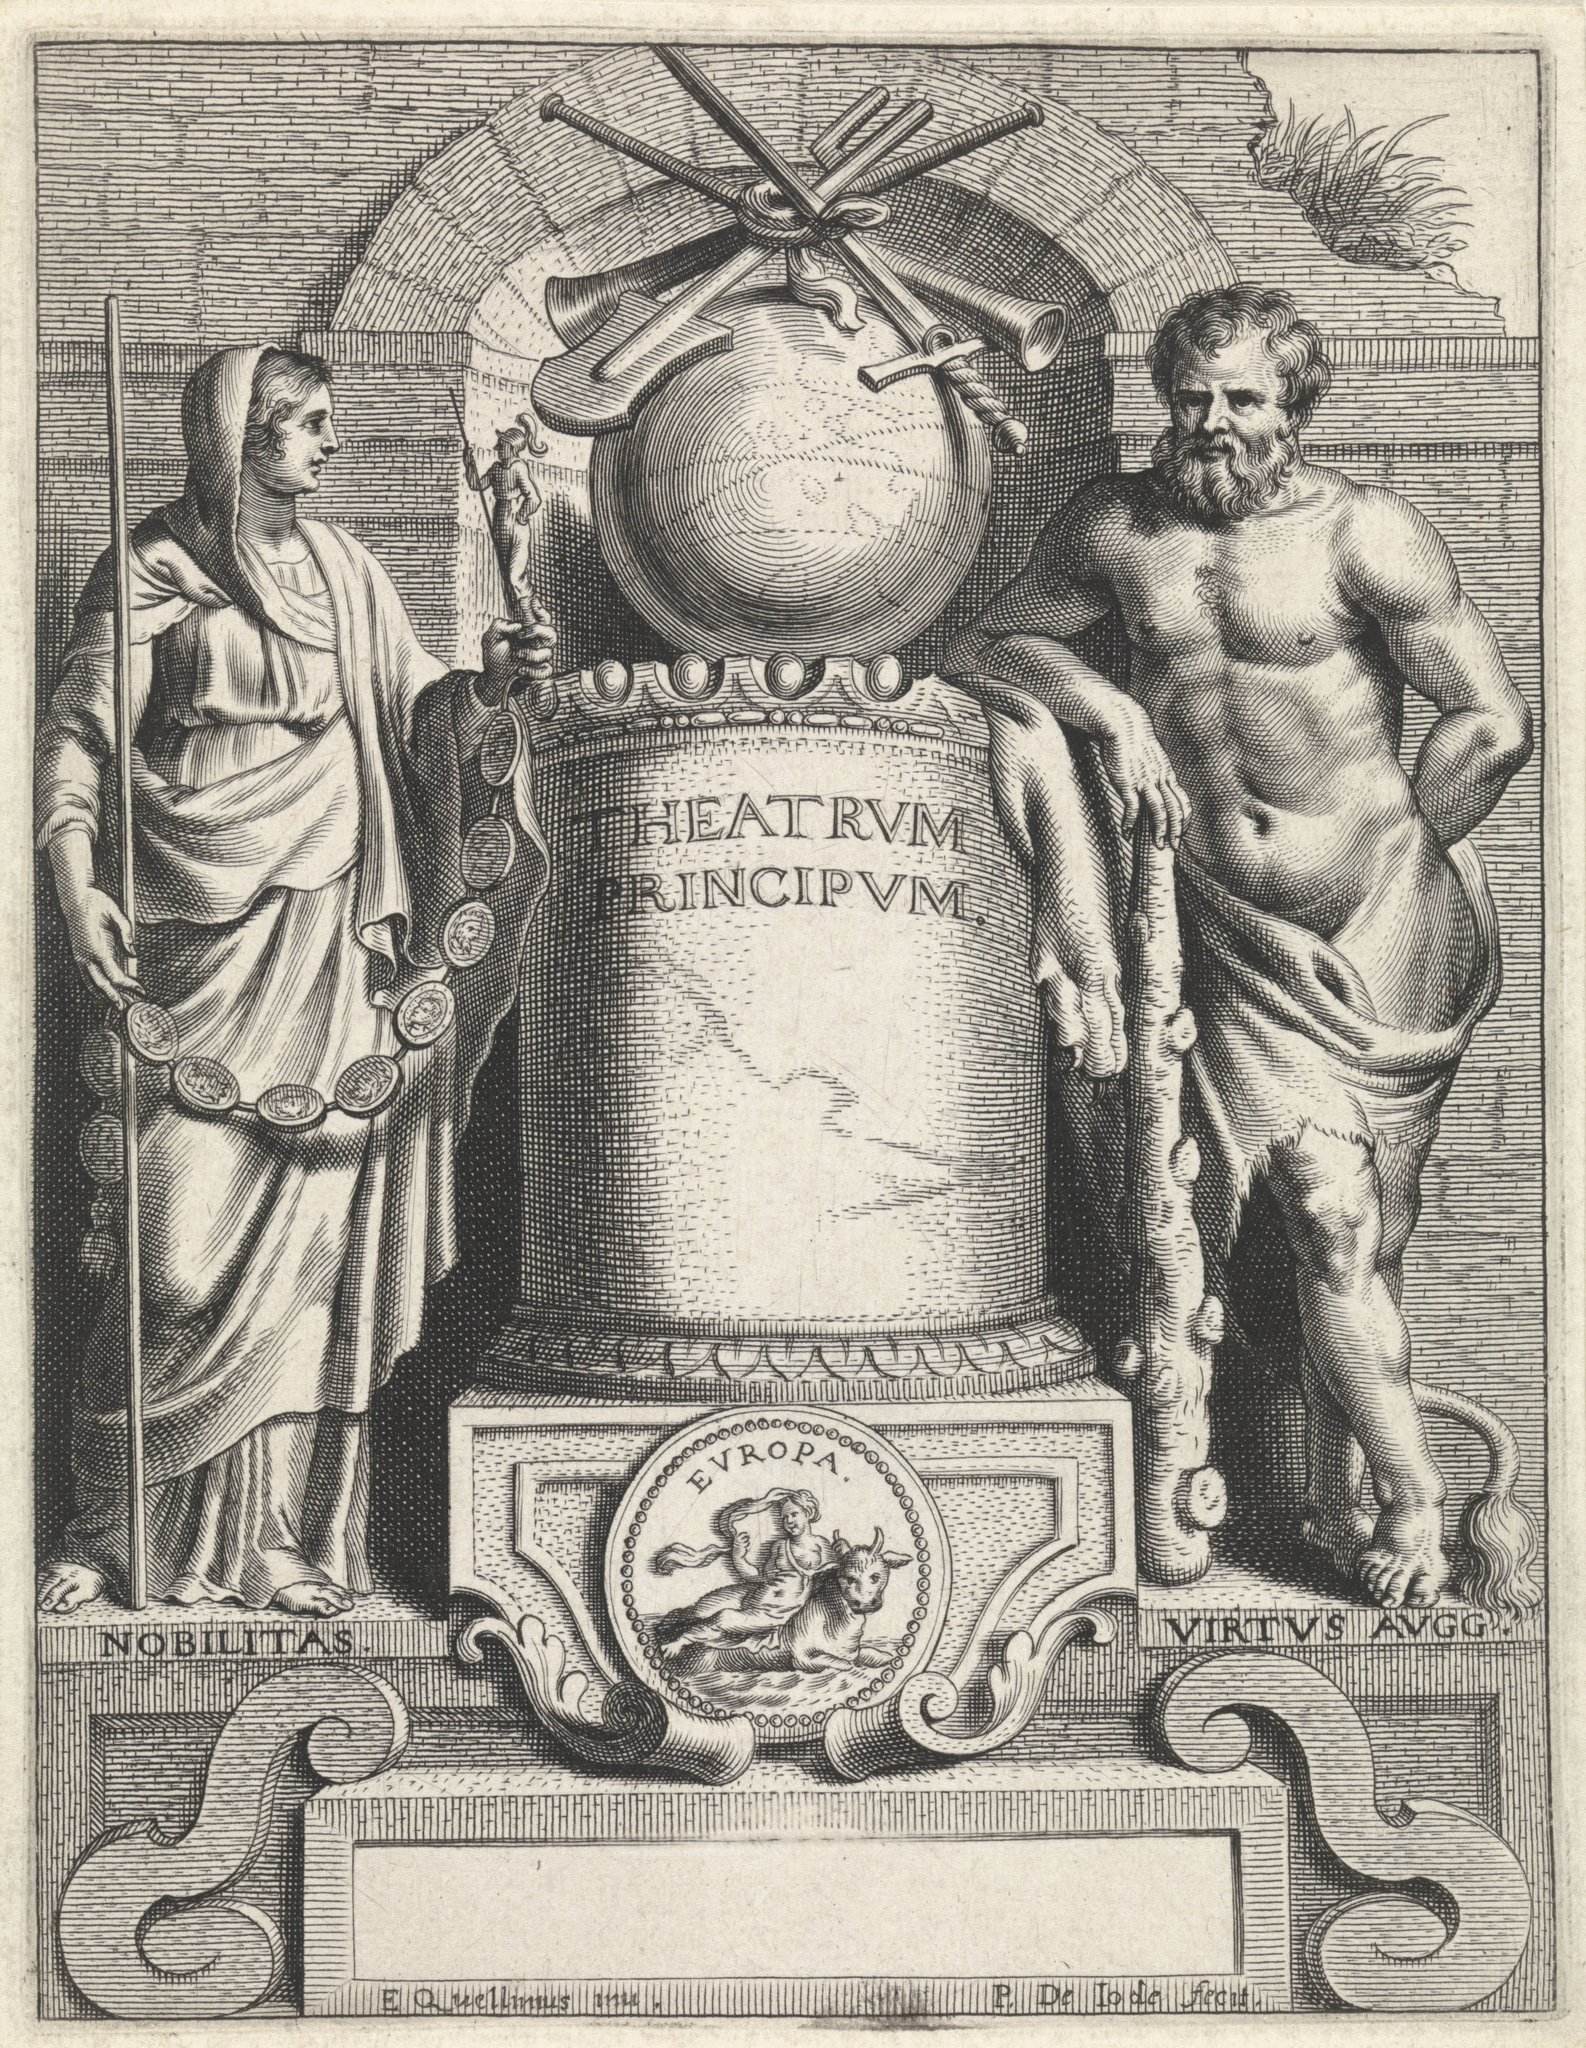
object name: print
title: Titelprent voor Theatrum Principum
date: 1638-1644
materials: paper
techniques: engraving, etching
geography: antwerp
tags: jupiter, usually in the shape of a white bull, abducts europa and carries her across the water, (story of) hercules (heracles), 'historia'; 'historia' (ripa)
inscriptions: collector's mark: Lugt 2228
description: Titelprent met de titel in het Latijn op een piëdestal, geflankeerd door de personificatie van Geschiedenis en Hercules. Boven het piëdestal een globe met trompetten, zwaard en een riem. In een cartouche onder het piëdestal een medaillon met Zeus en Europa. Titelprent voor een serie van honderdtachtig prenten met portretten.